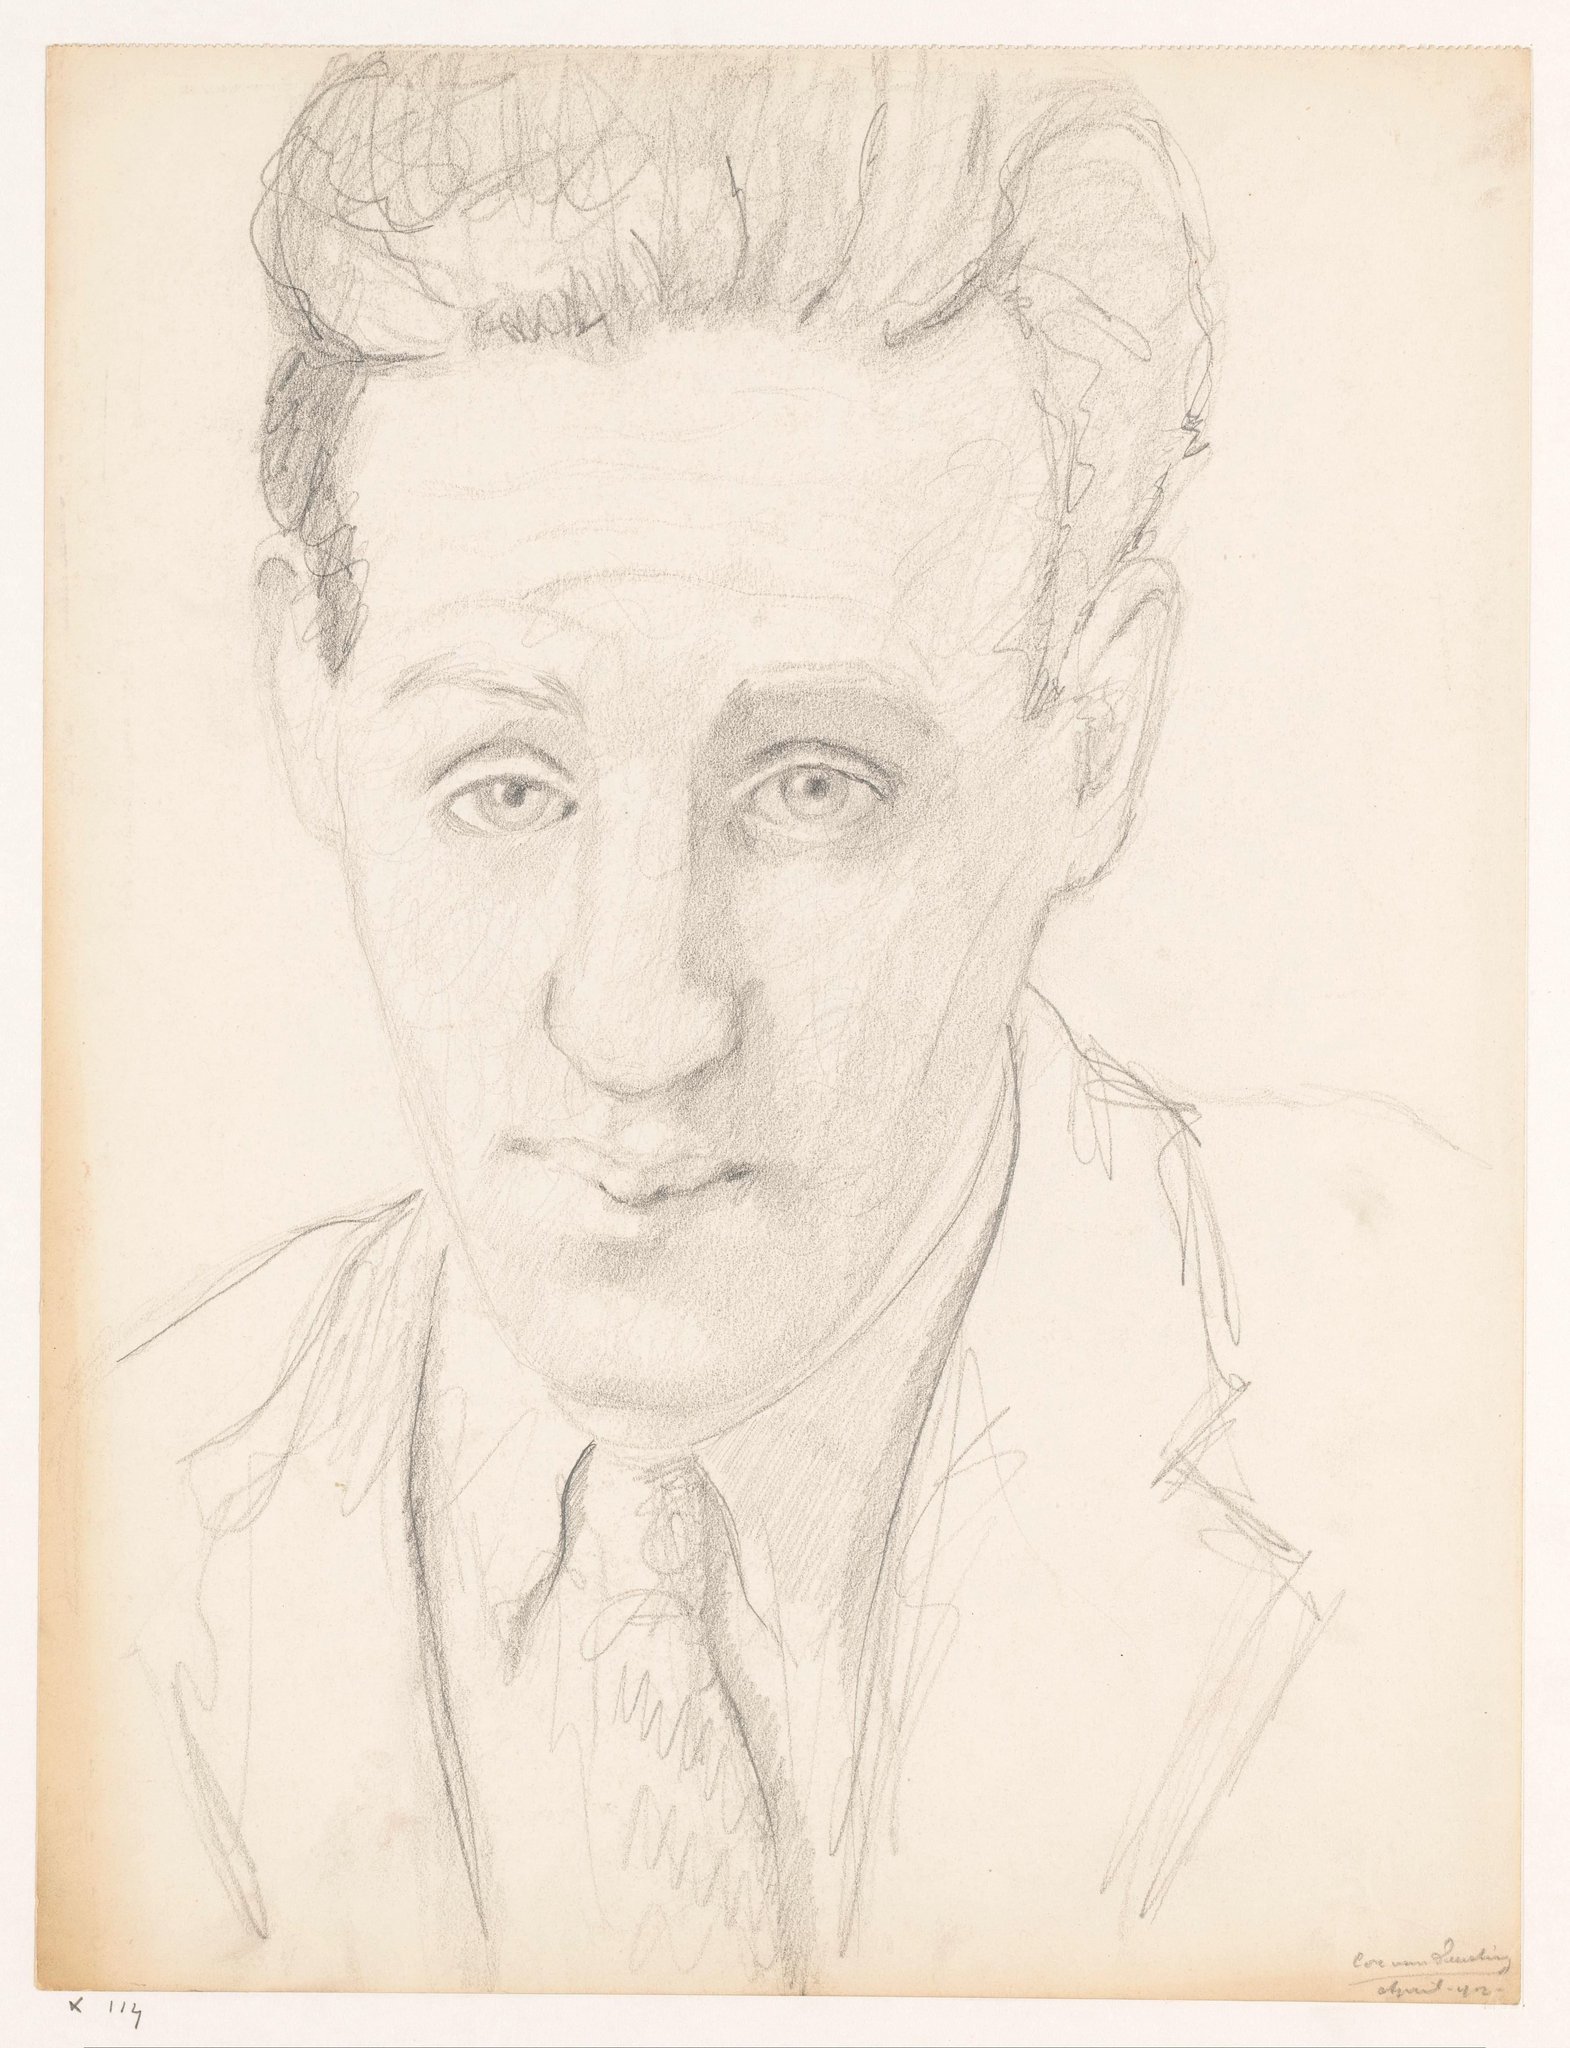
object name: drawing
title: Zelfportret en face, april 1942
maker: cor van teeseling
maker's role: draughtsman, sculptor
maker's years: 1915-1942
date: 1904-1942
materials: paper, pencil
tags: amsterdam, draughtsman, sculptor, cor van teeseling, historical persons, prisoner in cell or locked place, portrait, self-portrait of draughtsman, netherlands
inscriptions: date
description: Zelfportret van Cor van Teeseling en face, april 1942.